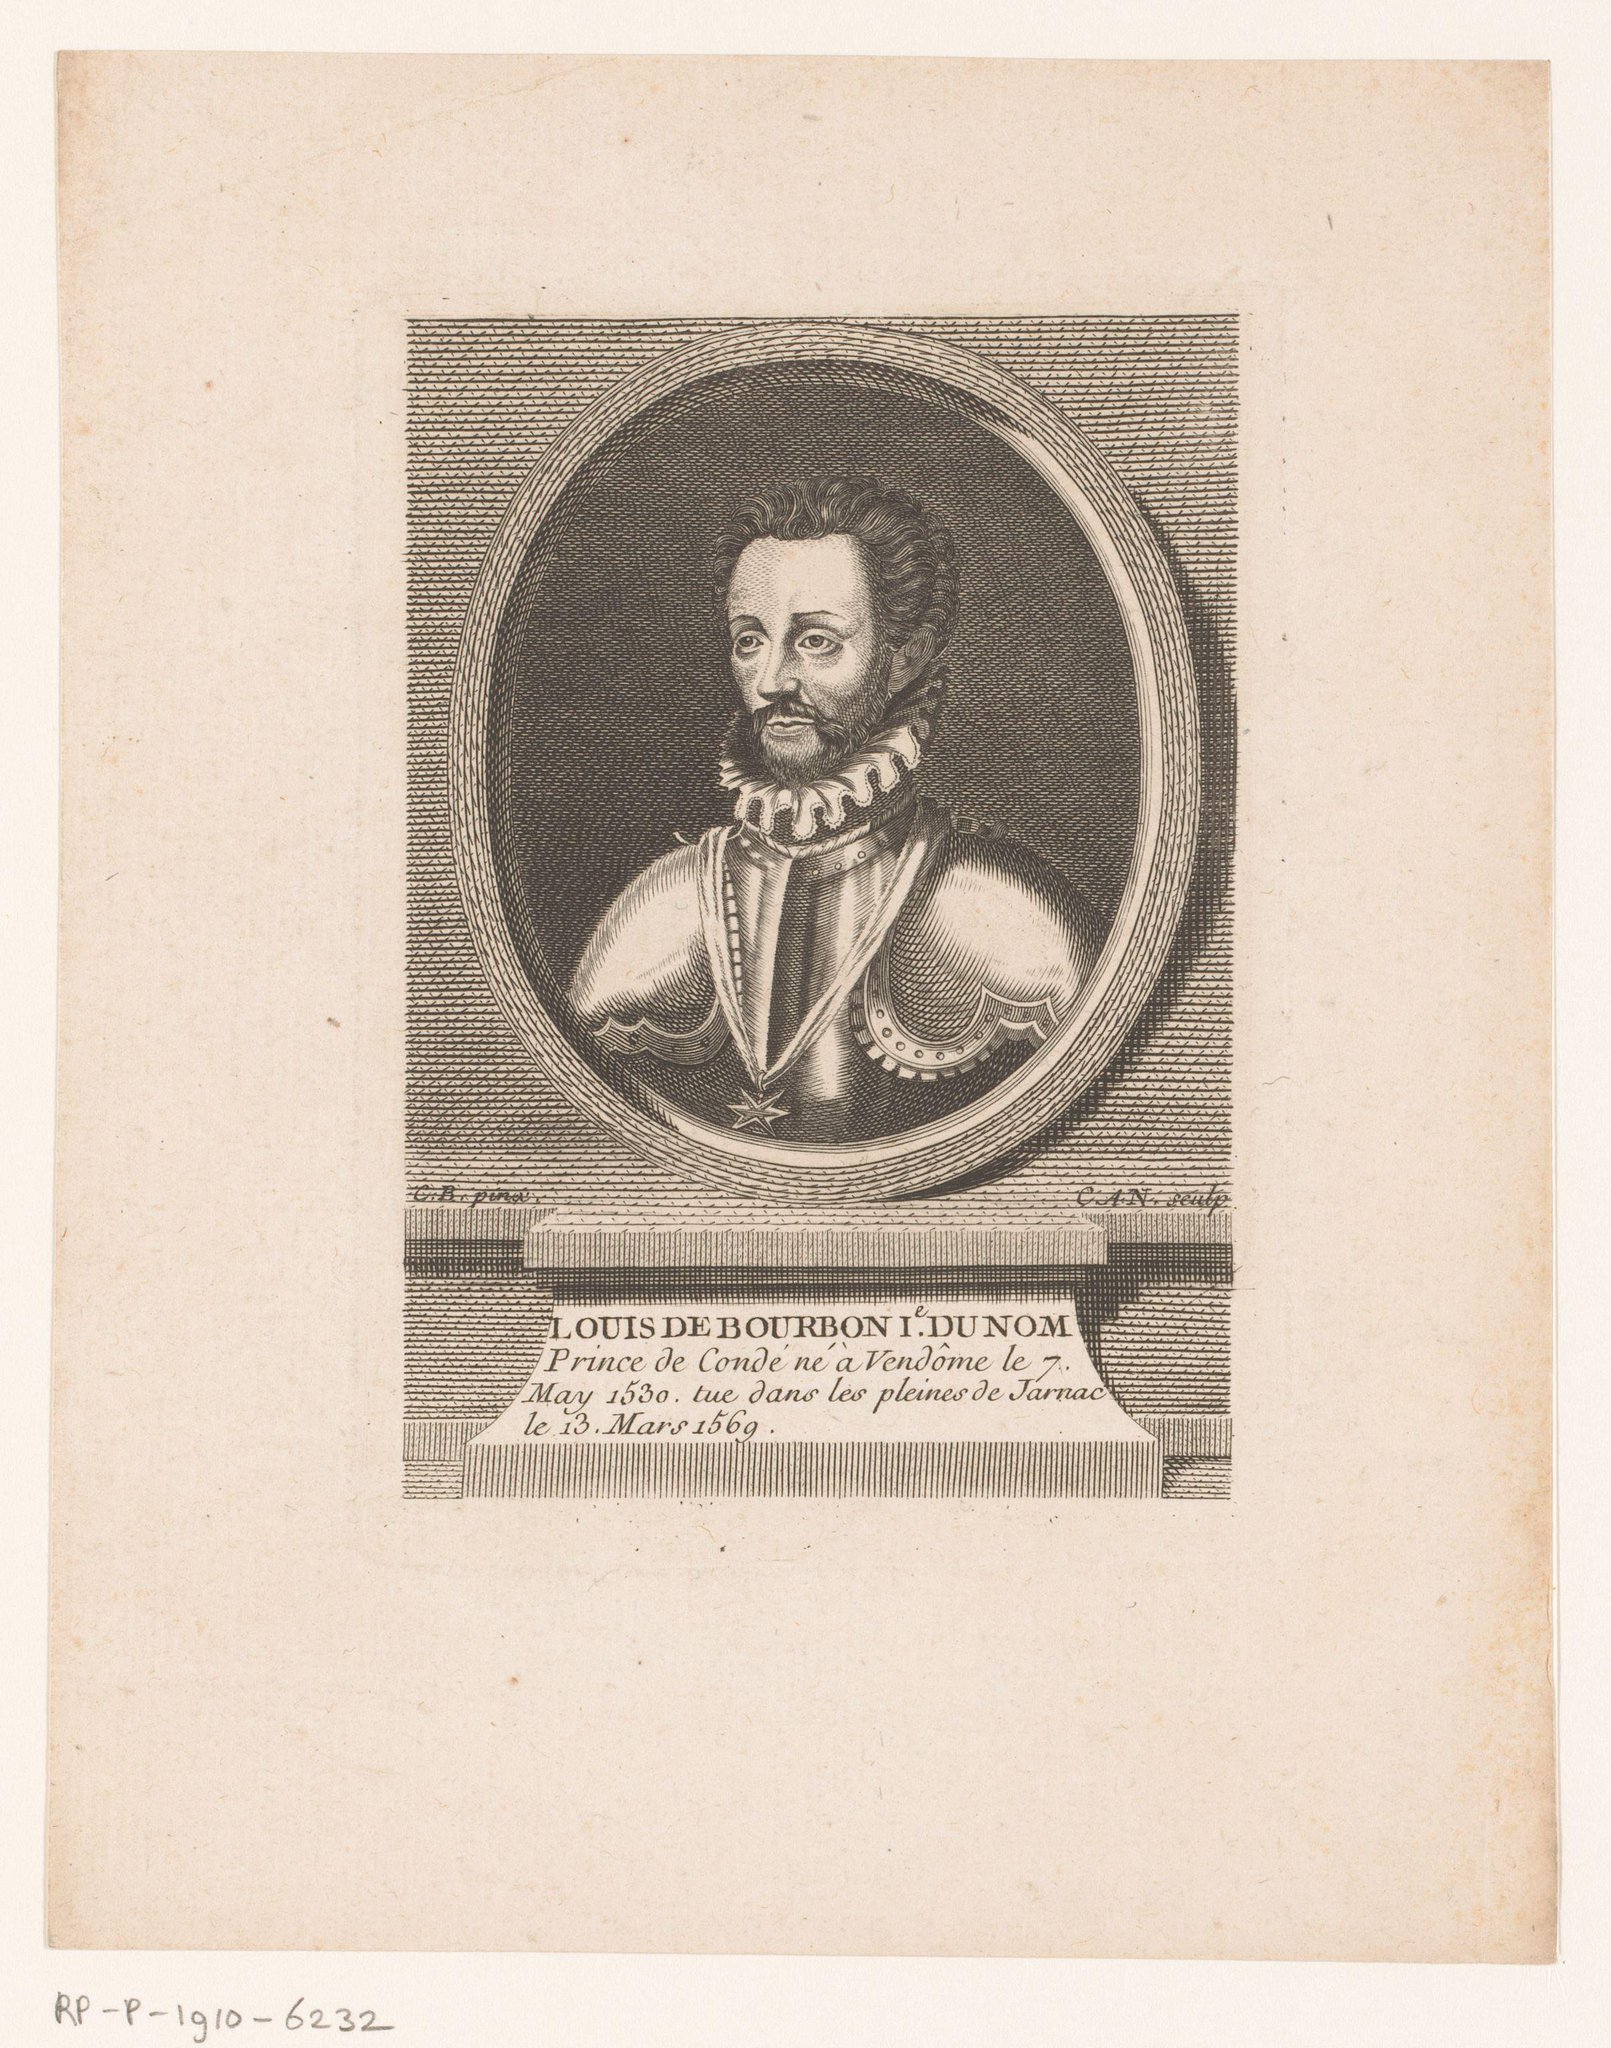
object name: print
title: Portret van Lodewijk I van Bourbon-Condé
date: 1700-1799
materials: paper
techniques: engraving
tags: historical persons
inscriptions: collector's mark: Lugt 2228